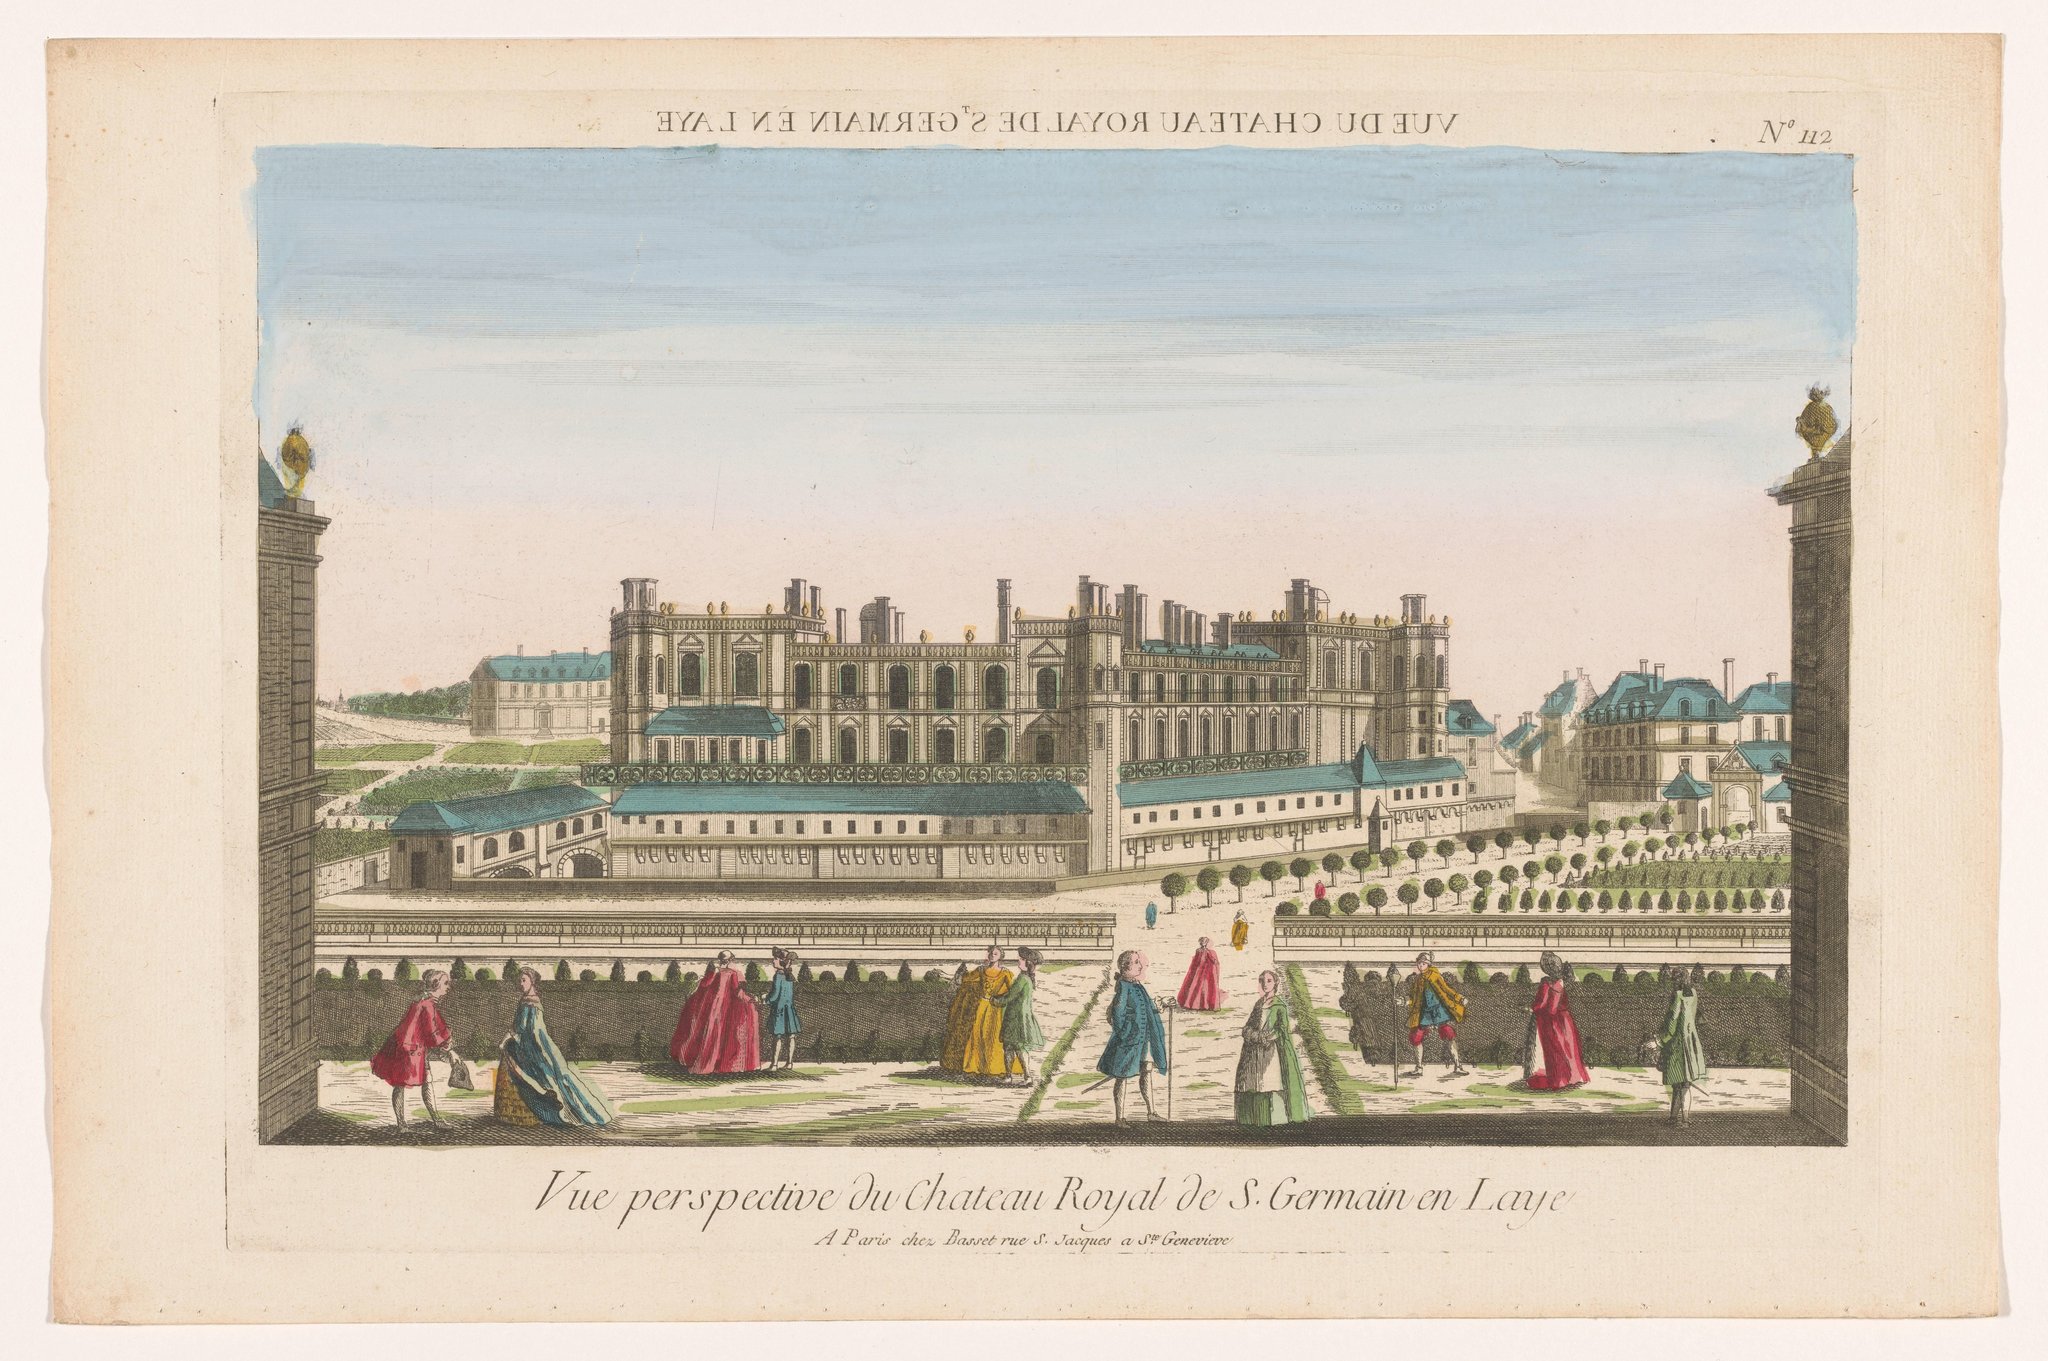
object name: print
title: Gezicht op het Château de Saint-Germain-en-Laye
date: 1700-1799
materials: paper, watercolor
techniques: brush, etching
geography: france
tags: civic architecture; edifices; dwellings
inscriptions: collector's mark: Lugt 2166